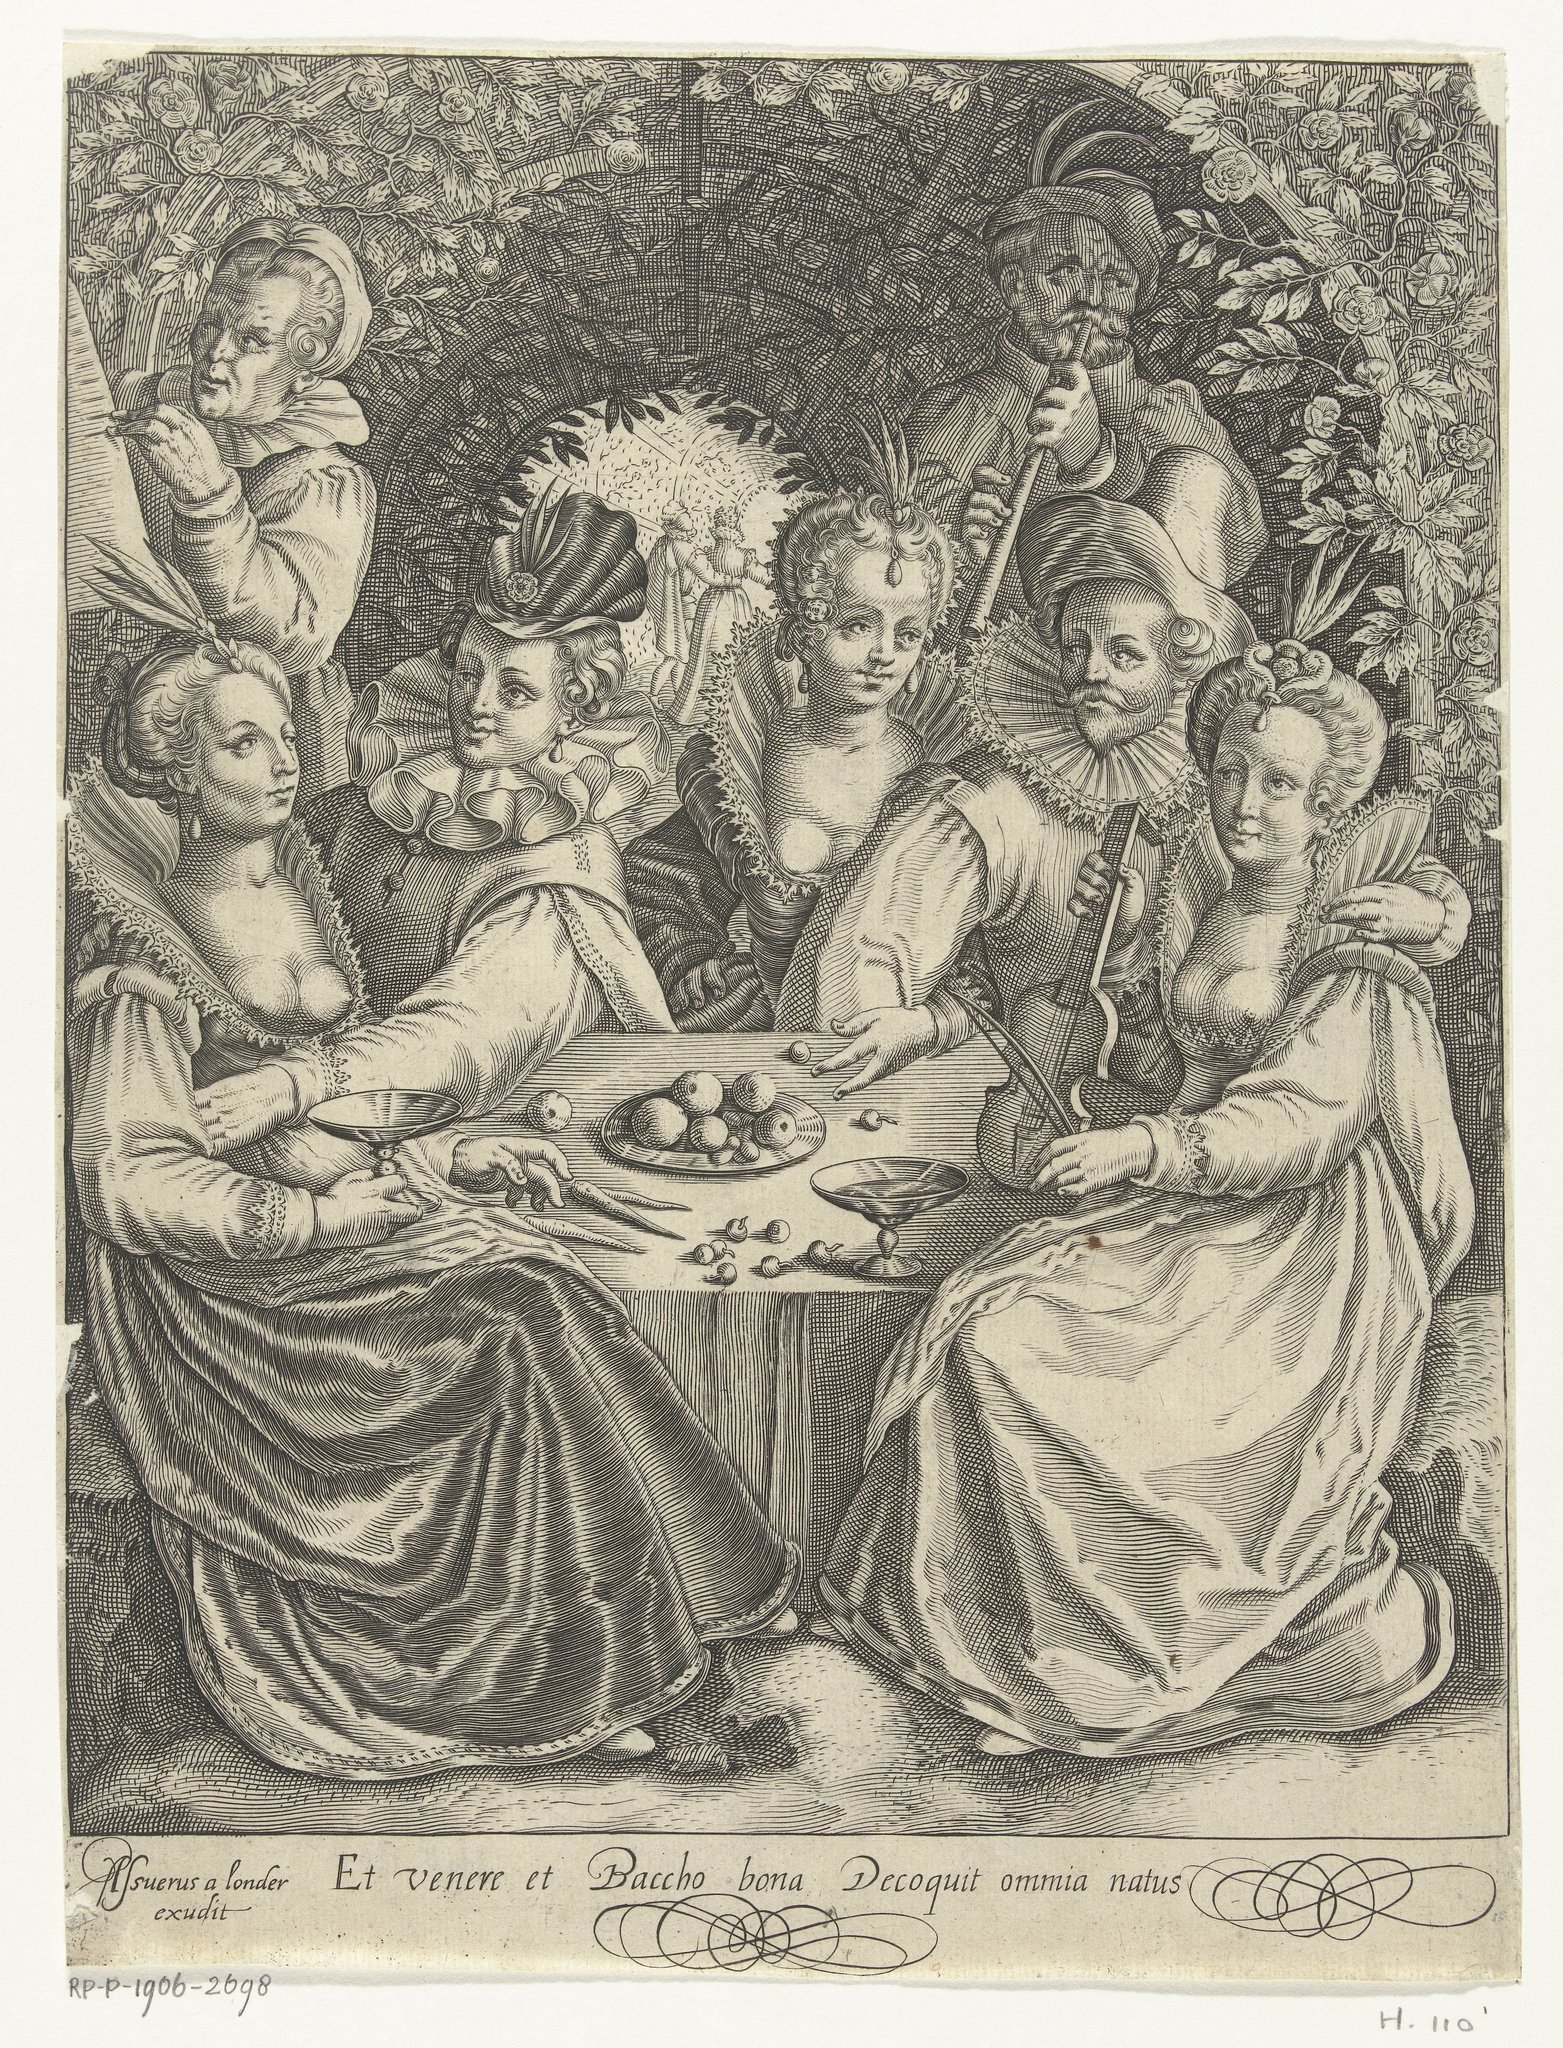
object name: print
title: Et venere et Baccho bona Decoquit ommia natus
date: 1581-1656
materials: paper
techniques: engraving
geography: netherlands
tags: clothes, costume (+ women's clothes), clothes, costume (+ men's clothes), breasts - aa - female human figure, the prodigal son in the midst of prostitutes feasting and dissipating his patrimony, usually in a brothel or inn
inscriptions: collector's mark: Lugt 2228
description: De verloren zoon verspilt zijn erfenis bij de hoeren. Hij laat zich vermaken met muziek en welwillende dames zittend aan een tafel in een tuin.